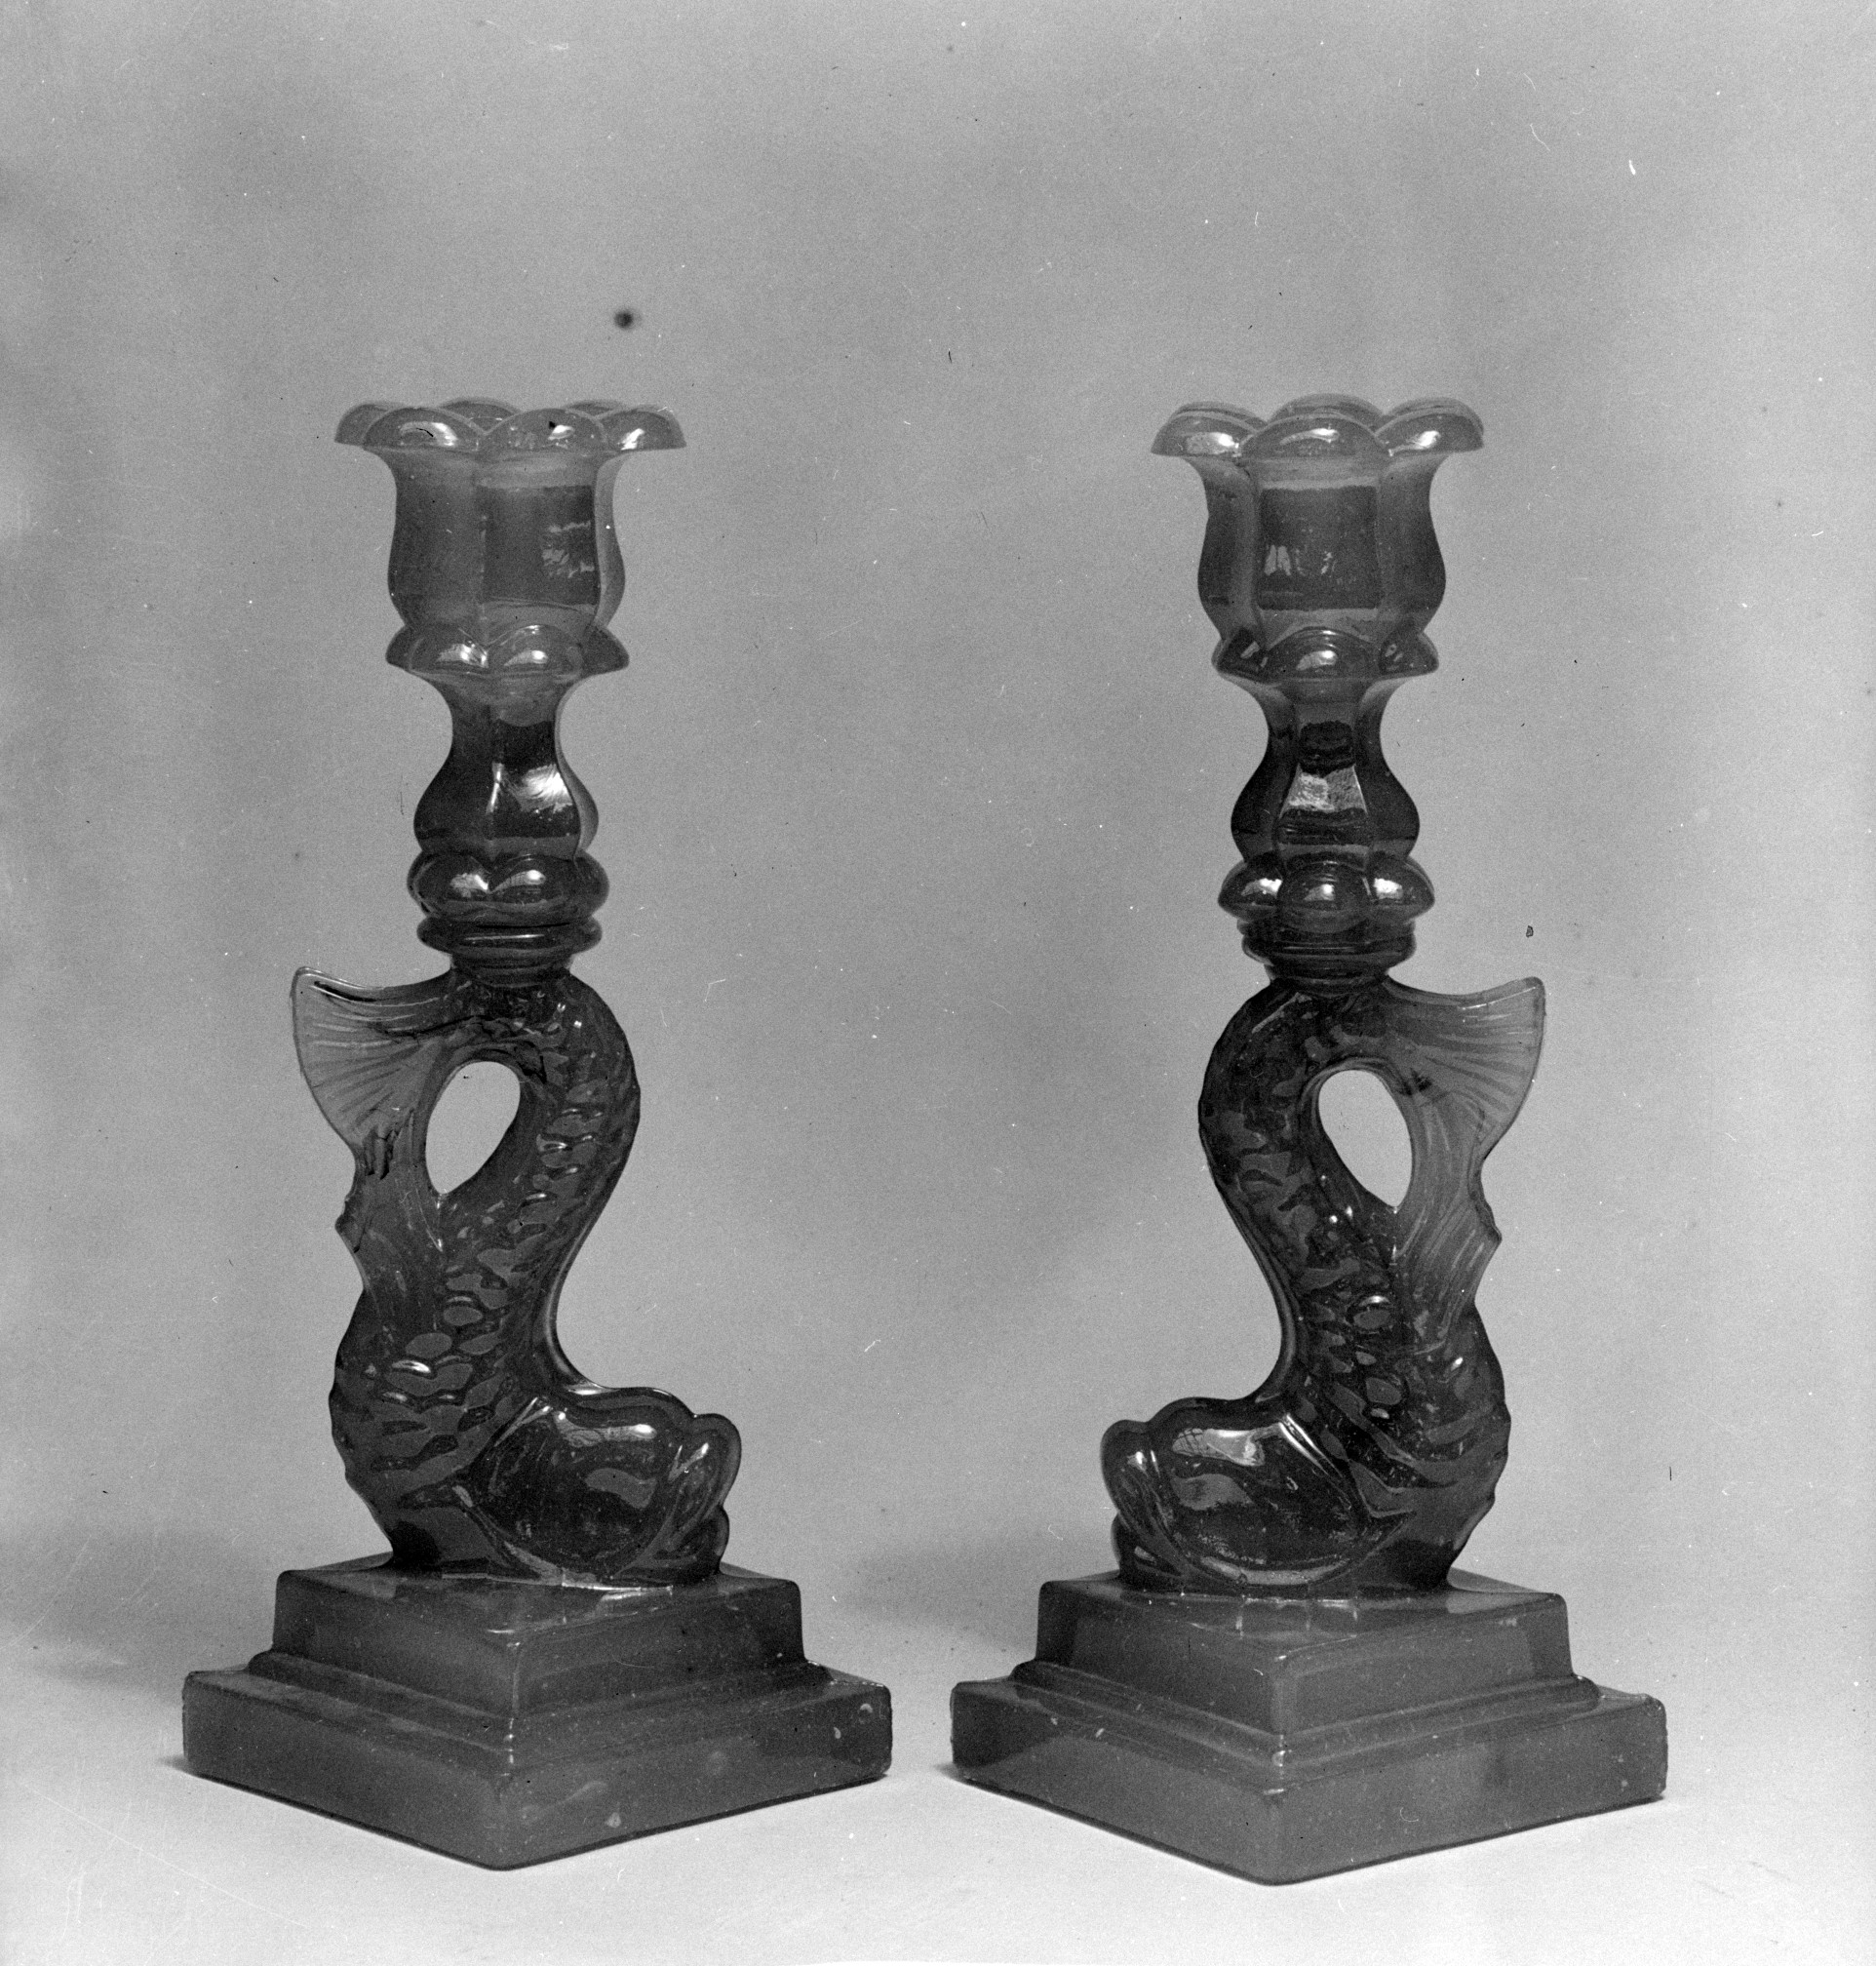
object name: candlestick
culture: american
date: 1845-1870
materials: glass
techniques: pressed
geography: united states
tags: dolphins